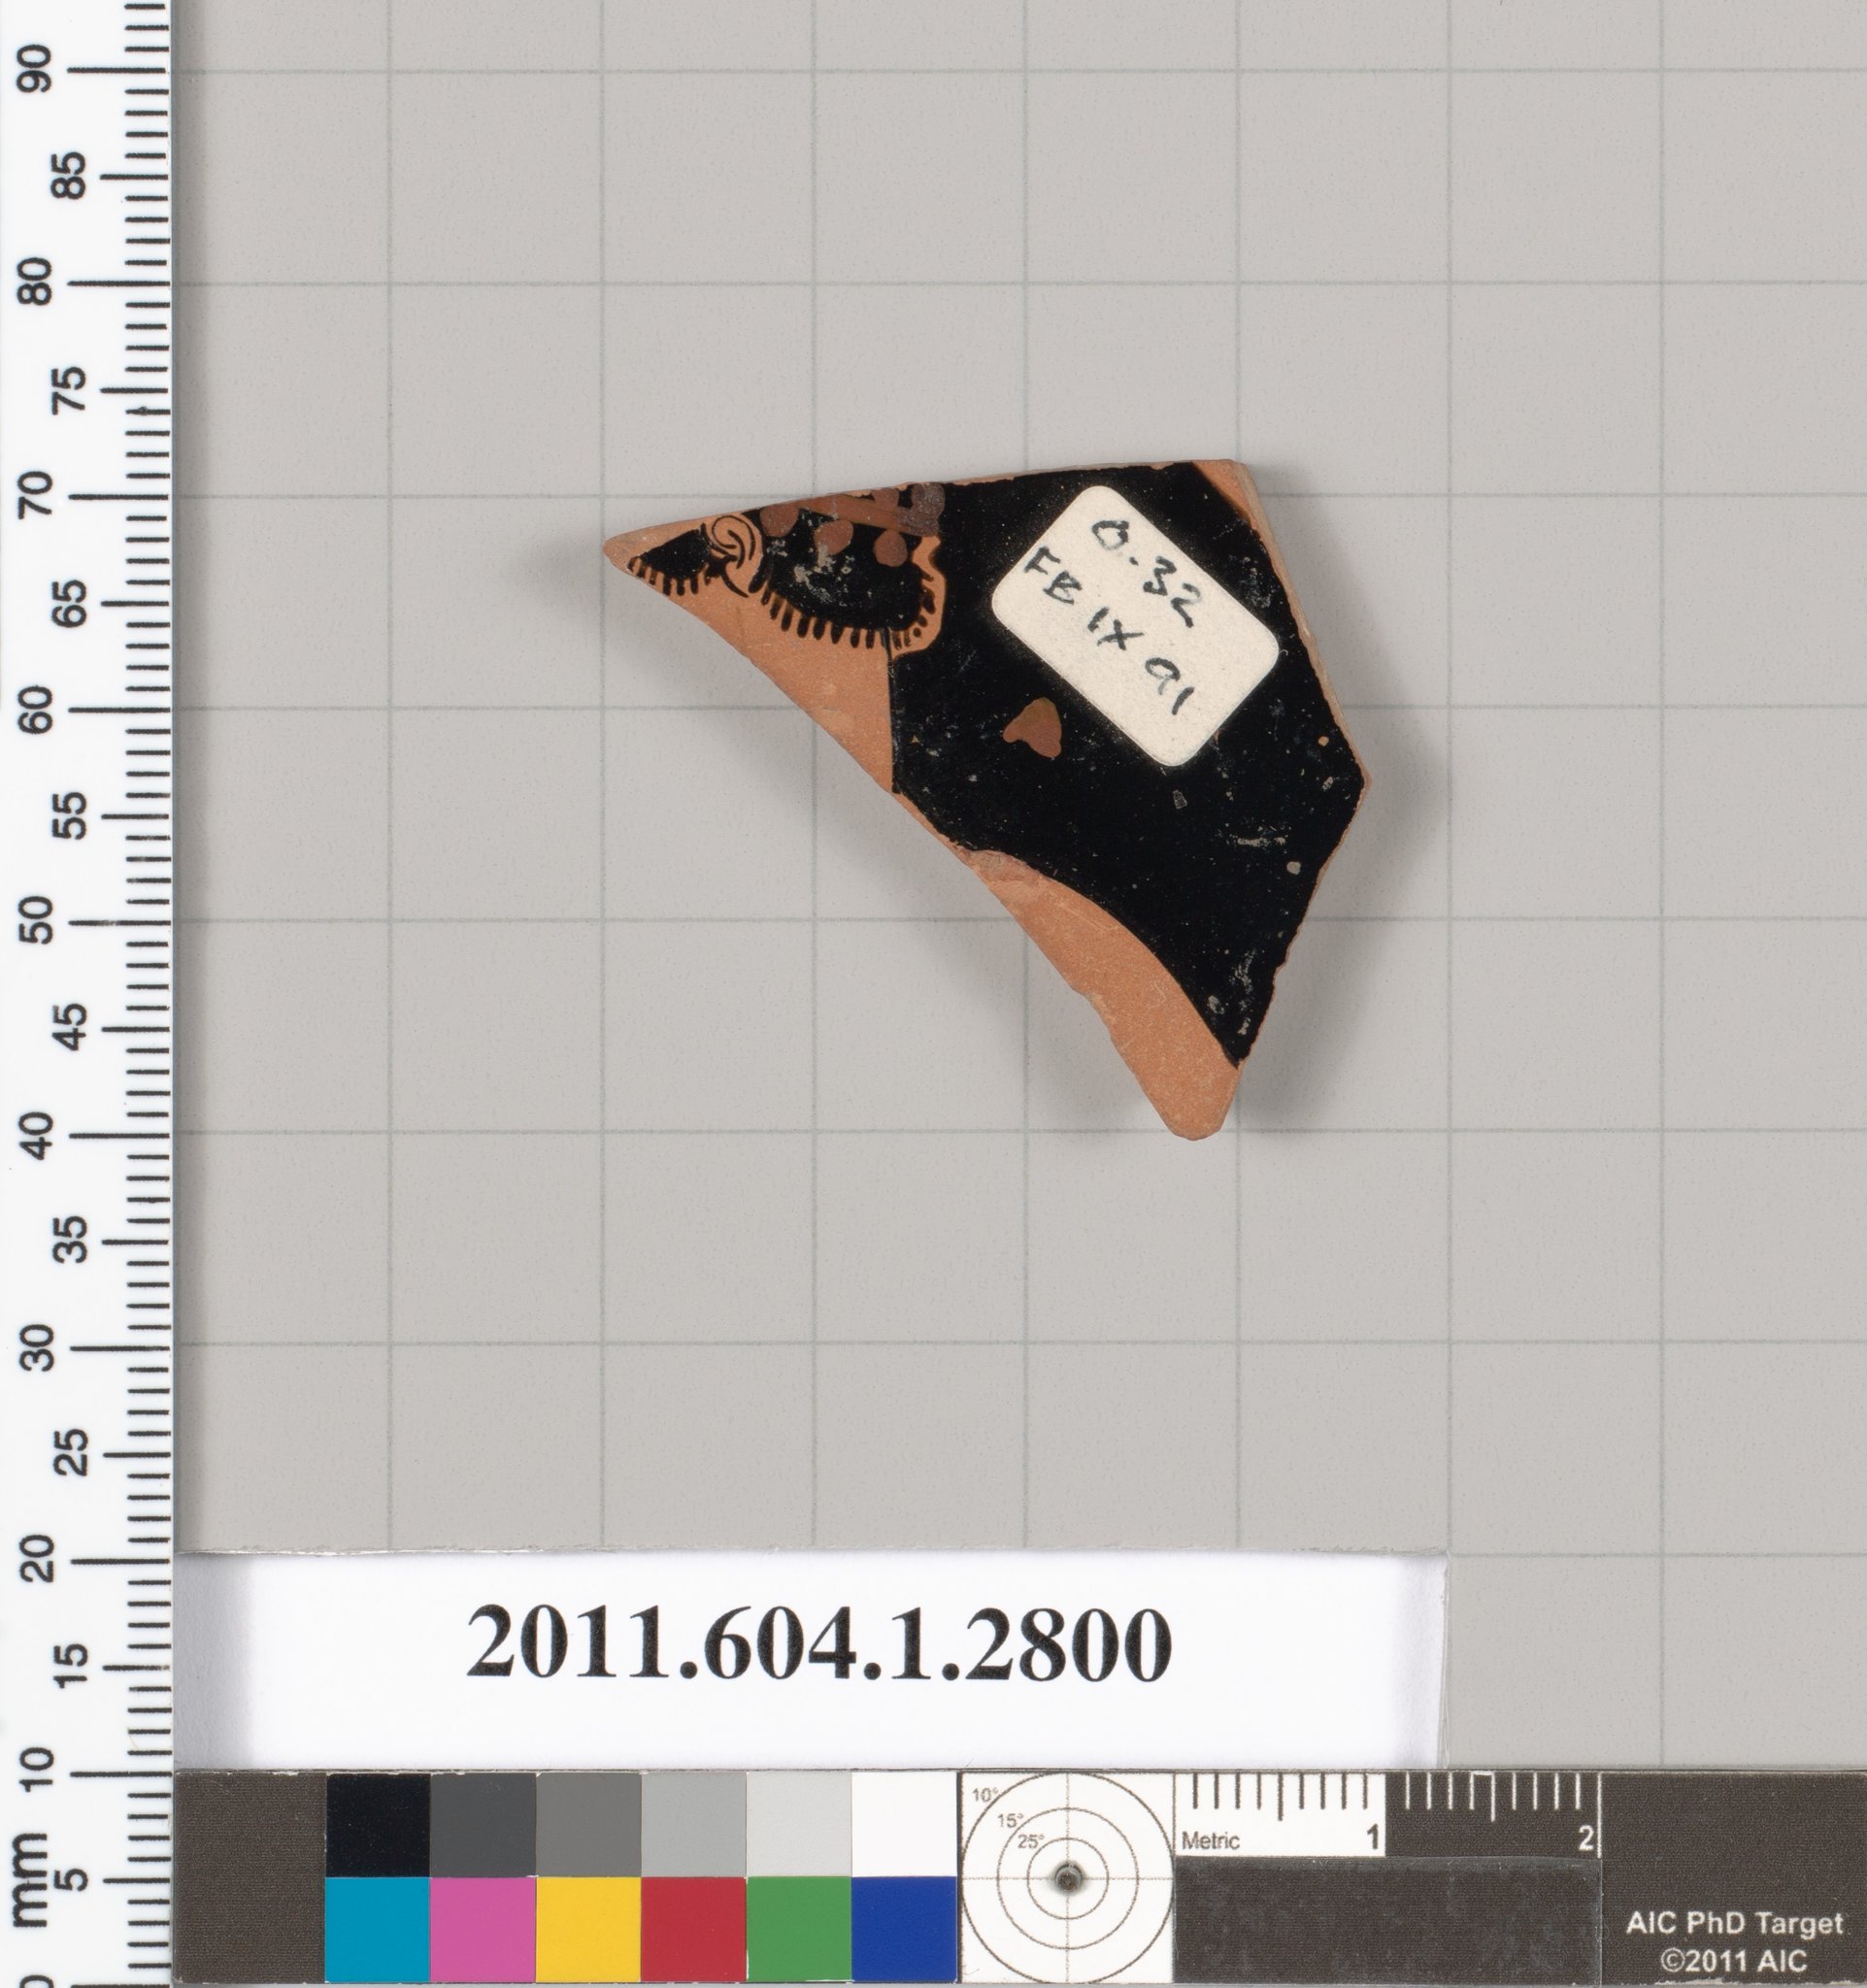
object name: kylix fragment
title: Terracotta fragment of a kylix (drinking cup)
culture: greek, attic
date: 520-500 BCE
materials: terracotta